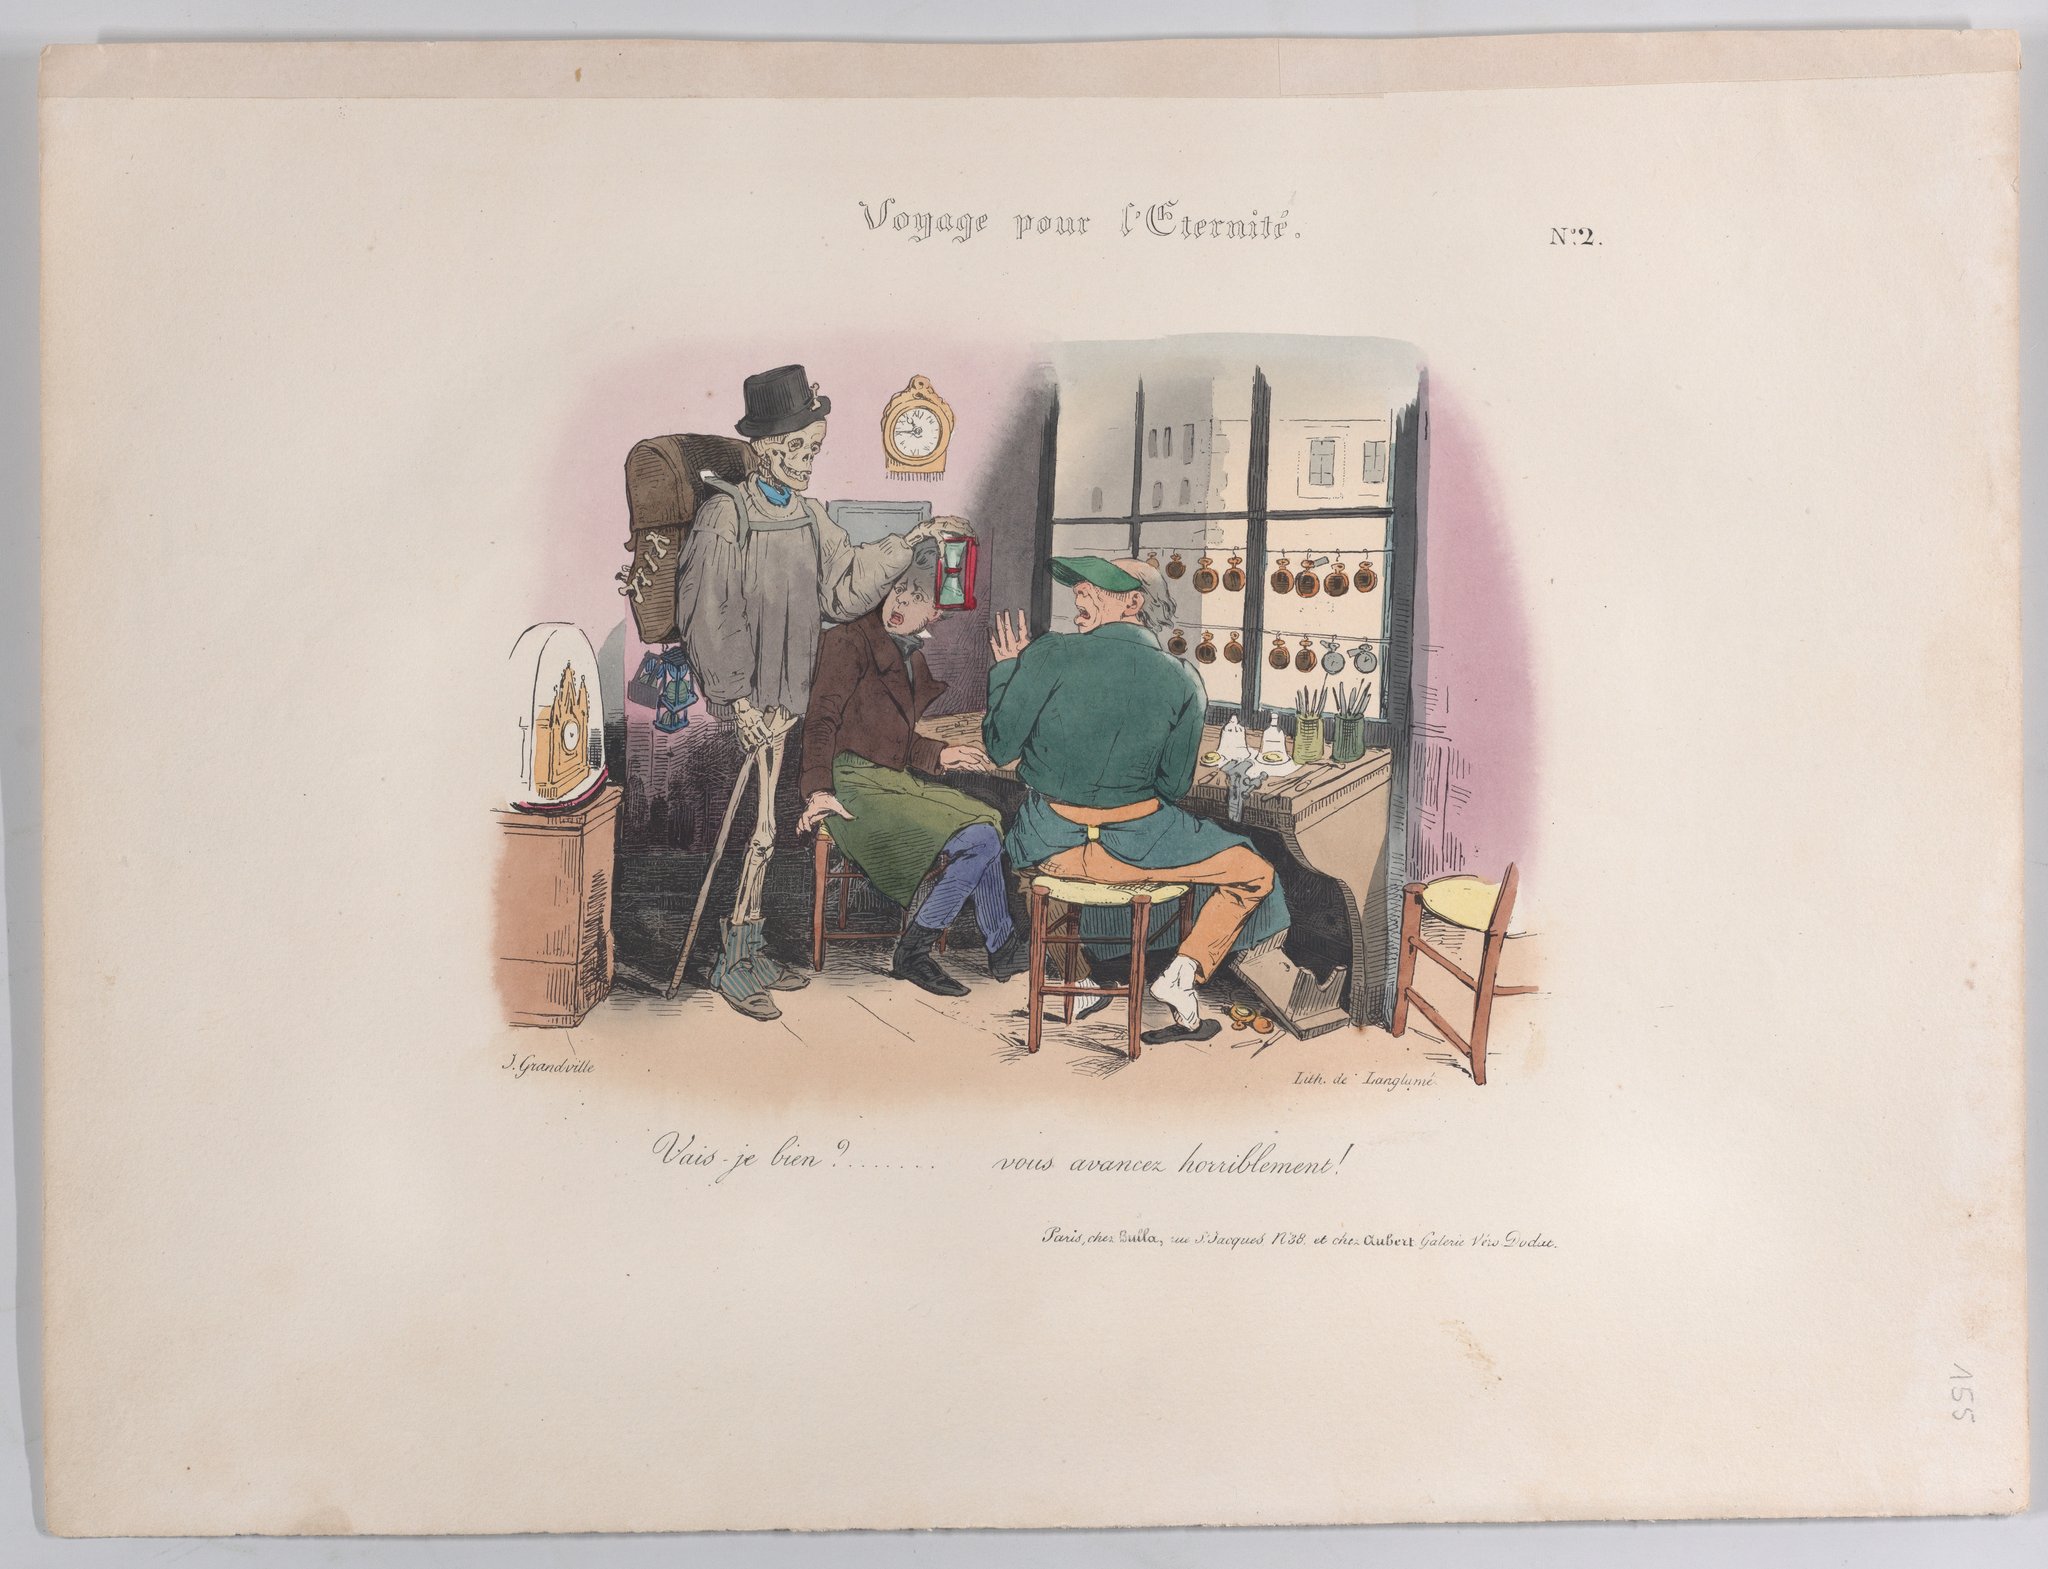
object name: print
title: Journey for Eternity, No. 4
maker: j. j. grandville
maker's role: designer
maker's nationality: french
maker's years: 1803-1847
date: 1839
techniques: lithograph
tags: watches,skeletons,men